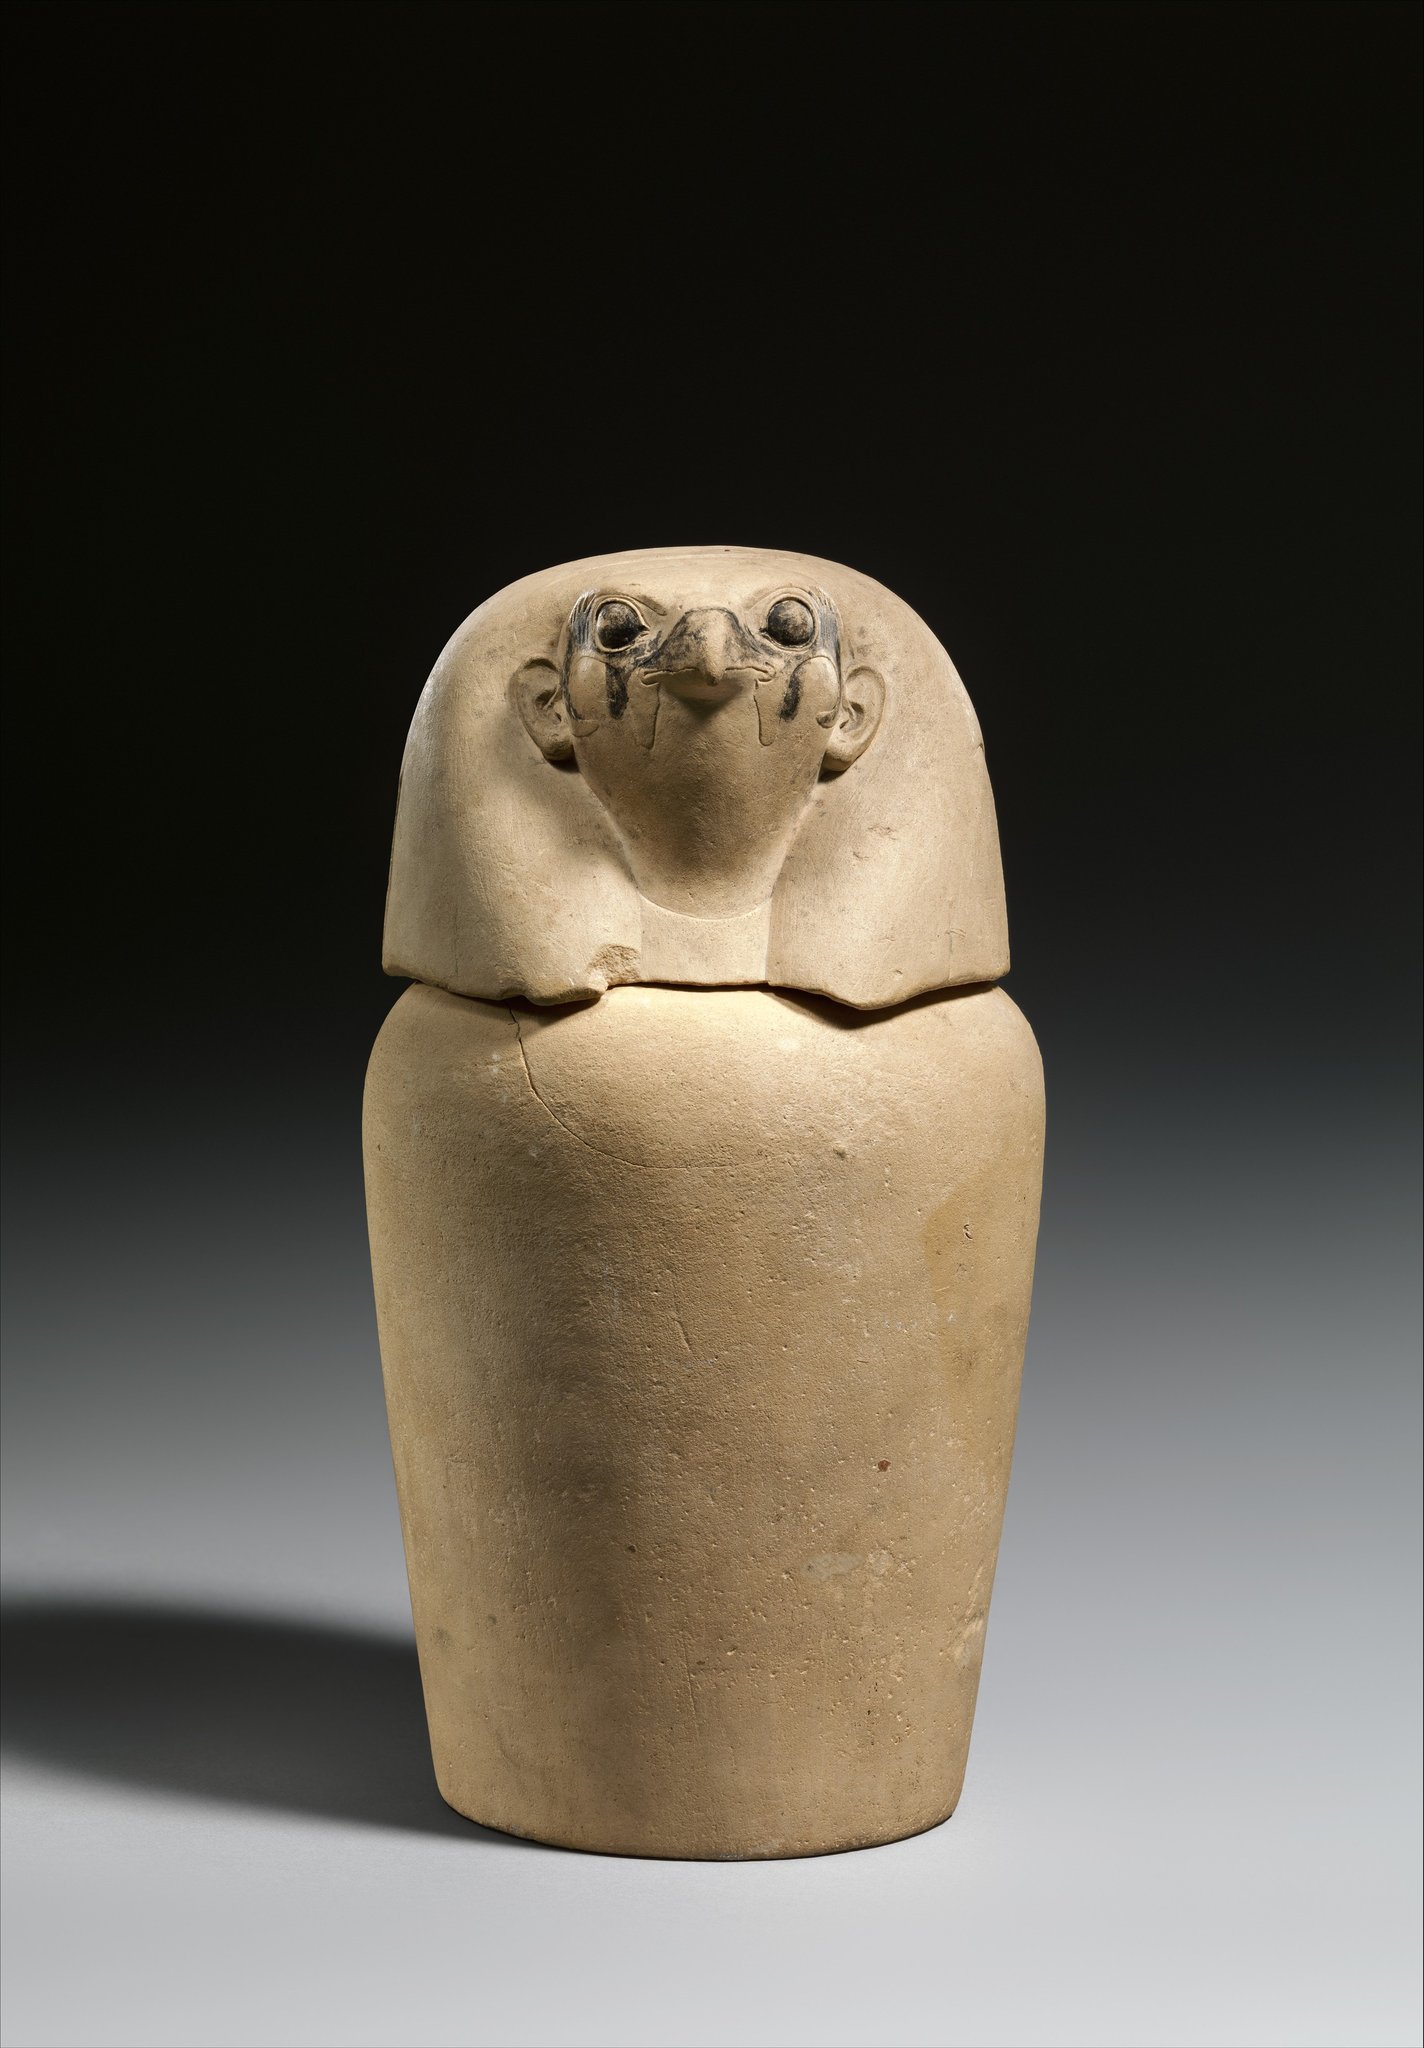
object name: canopic jar, falcon lid, qebehsenuef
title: Canopic Jar Representing the Deity Qebehsenuef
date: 664-525 BCE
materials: limestone, paint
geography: northern upper egypt